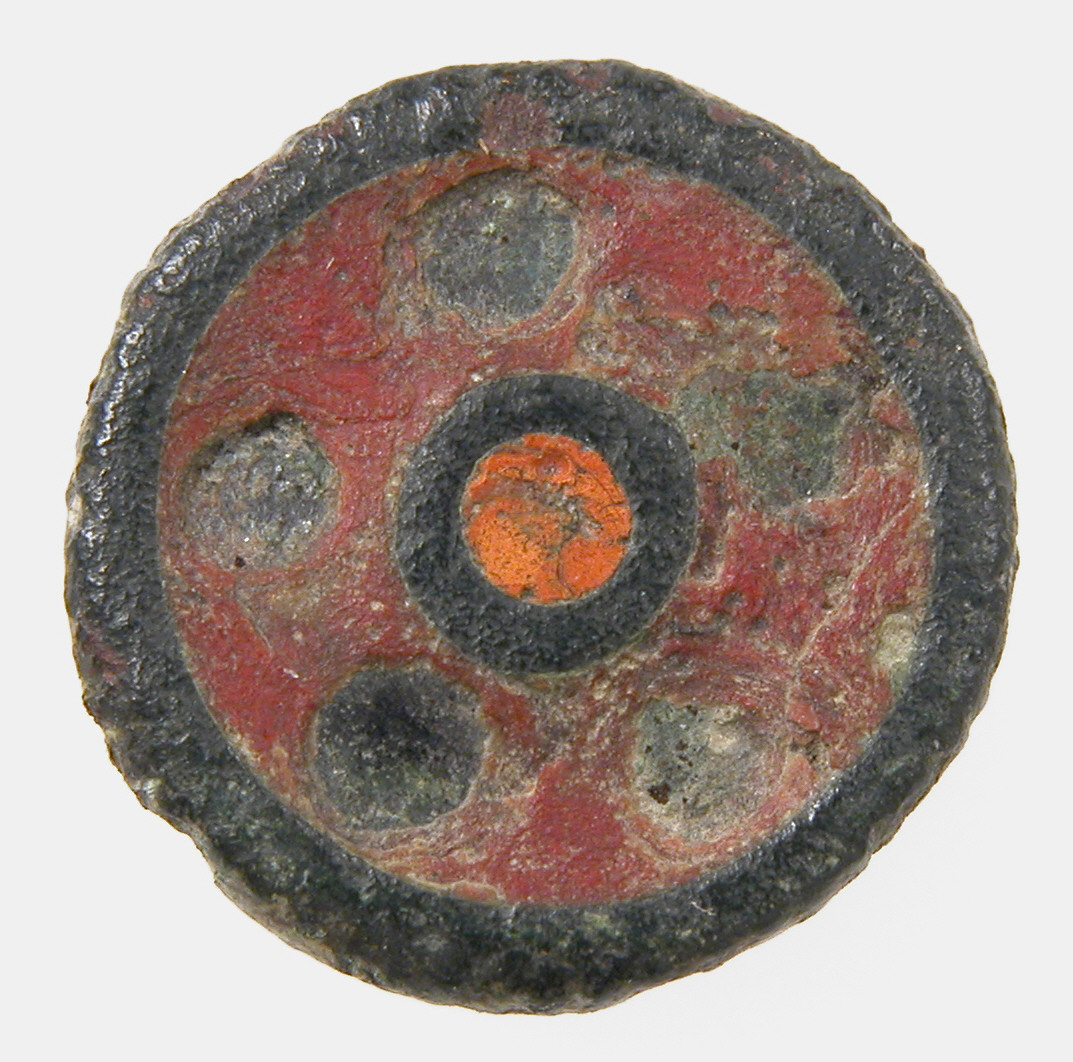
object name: button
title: Flat Button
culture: roman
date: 101-300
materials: copper alloy, enamel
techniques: enamel